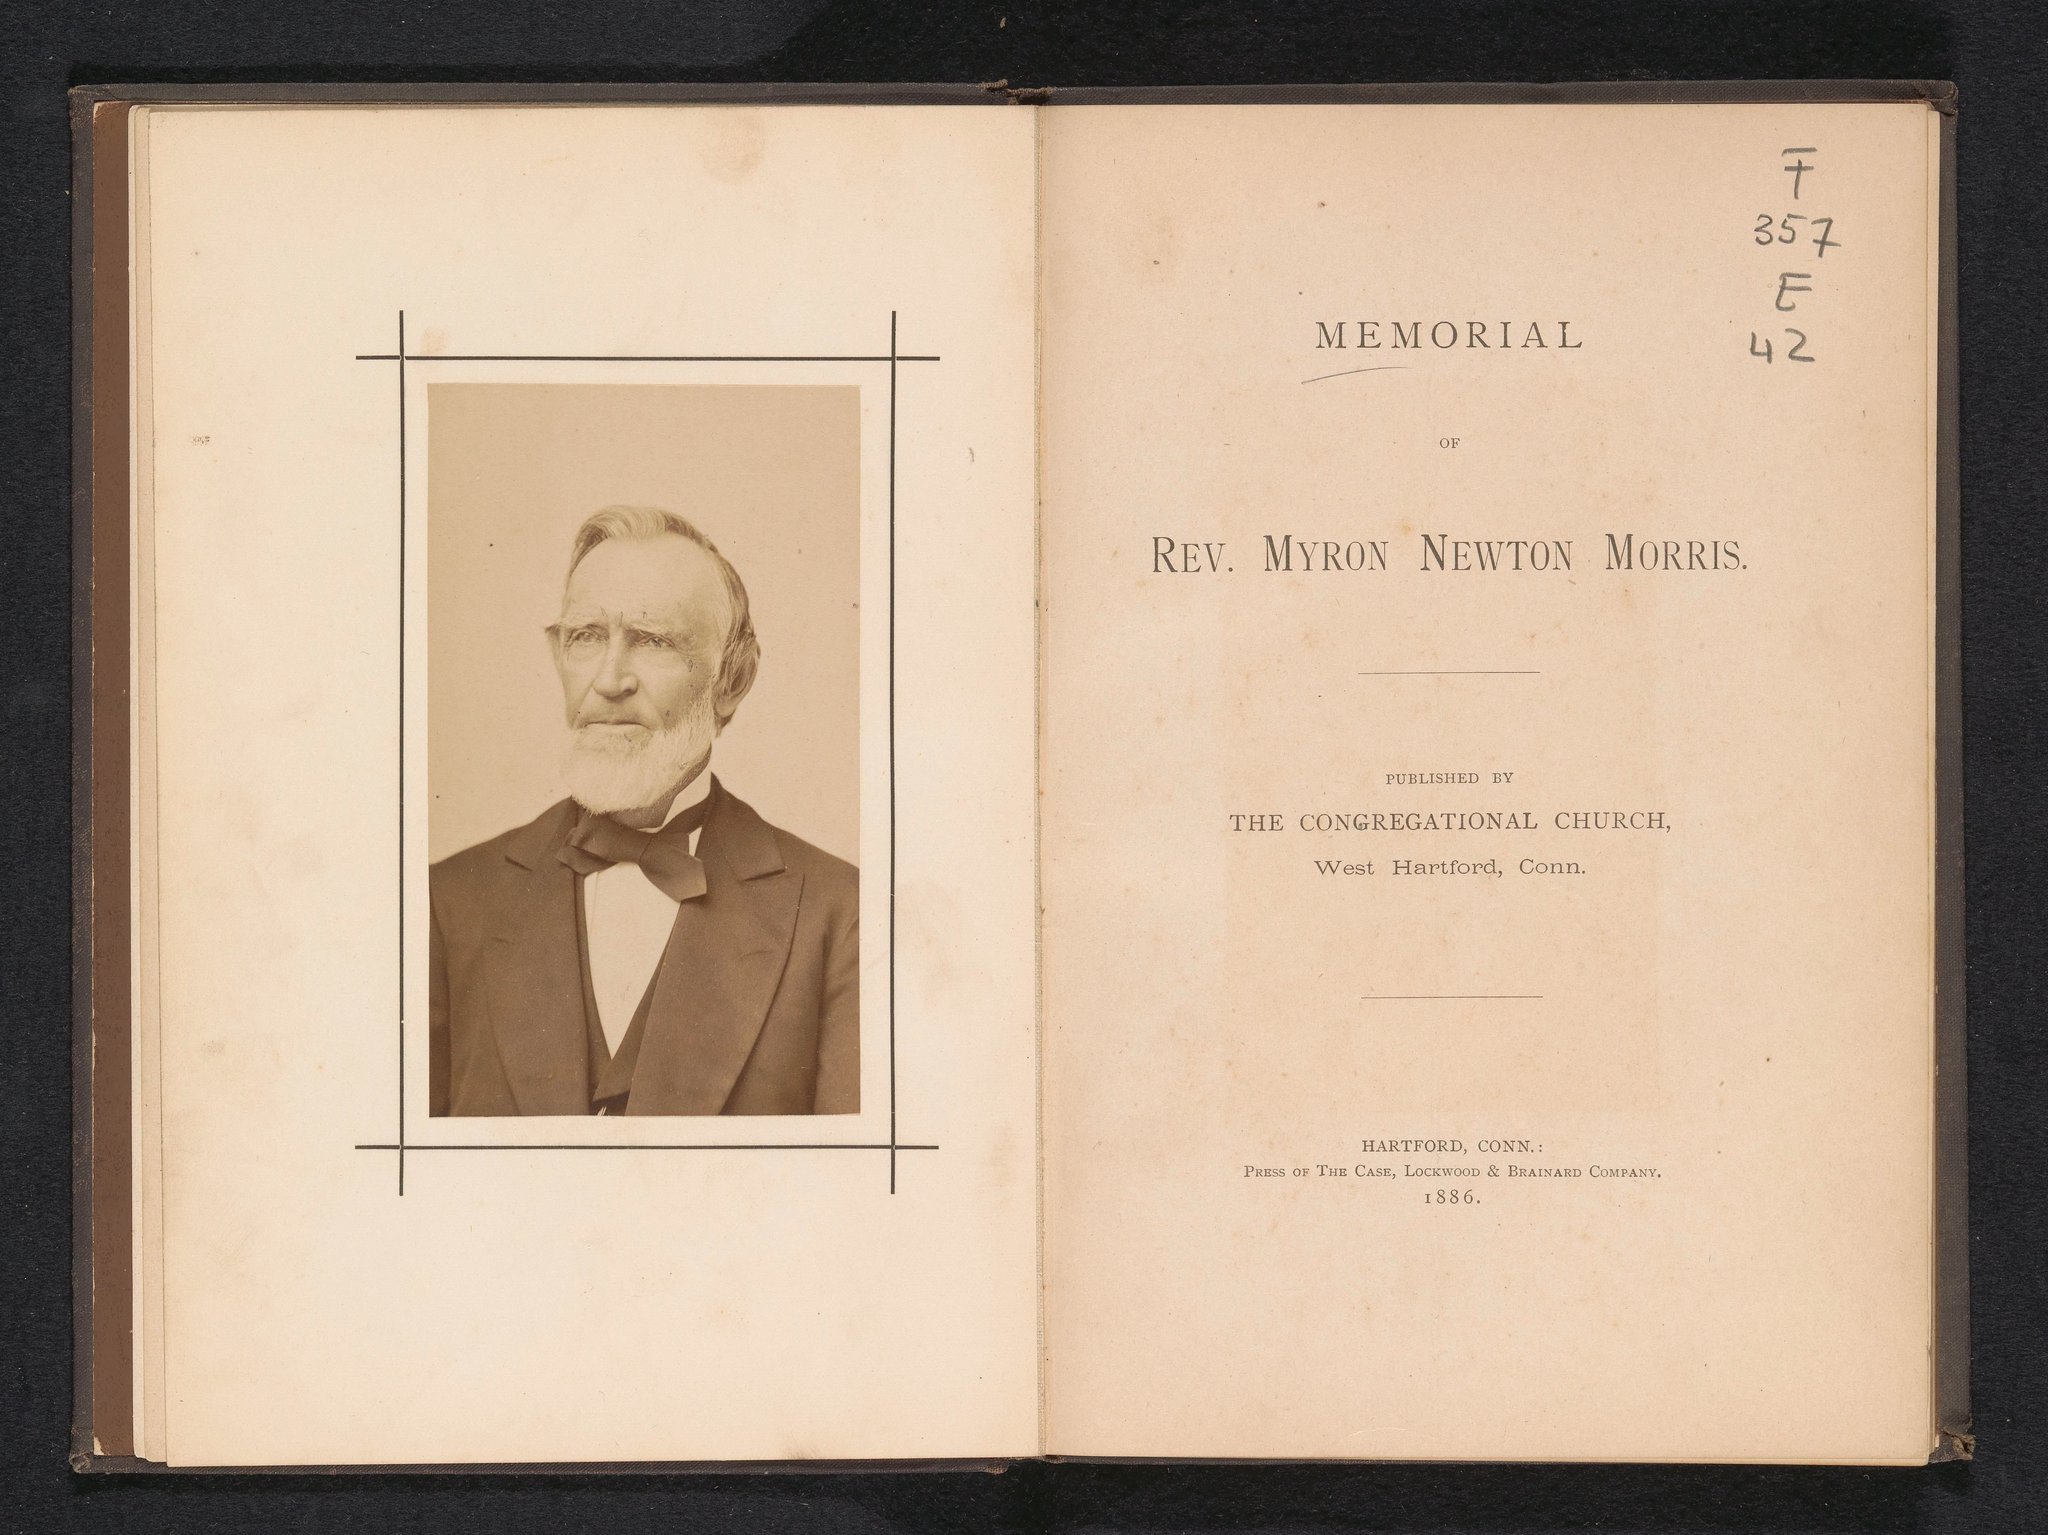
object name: book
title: Memorial of Rev. Myron Newton Morris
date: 1886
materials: cardboard, linen, paper, photographic support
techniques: albumen print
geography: hartford